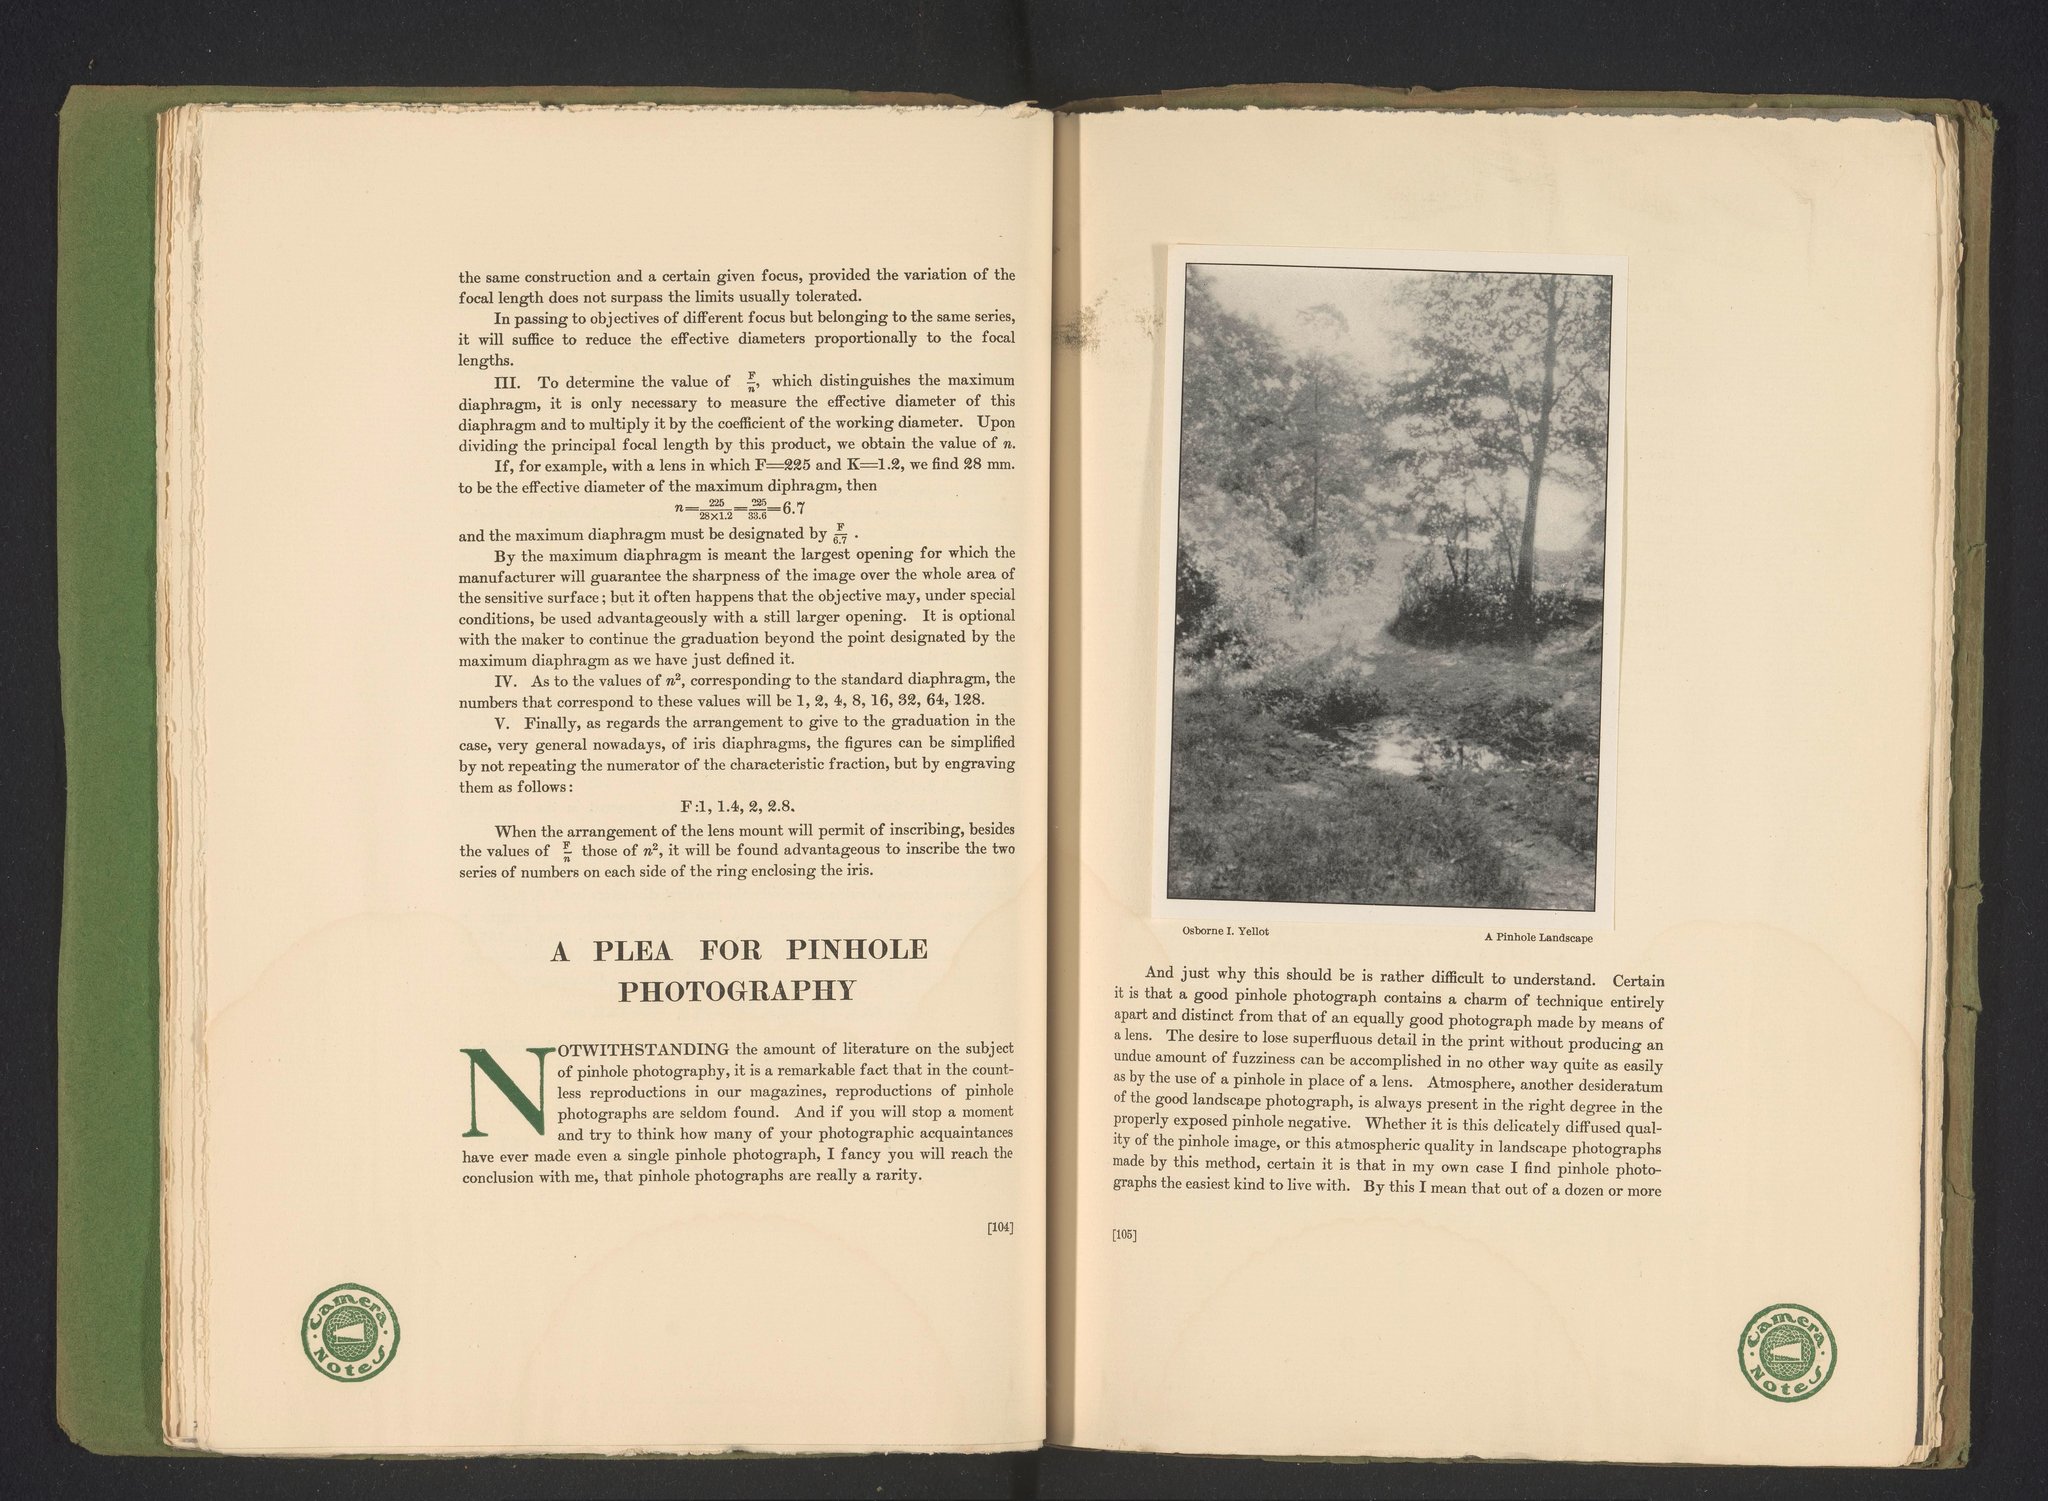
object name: photomechanical print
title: A Pinhole Landscape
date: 1897-1902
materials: paper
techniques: autotype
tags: landscapes